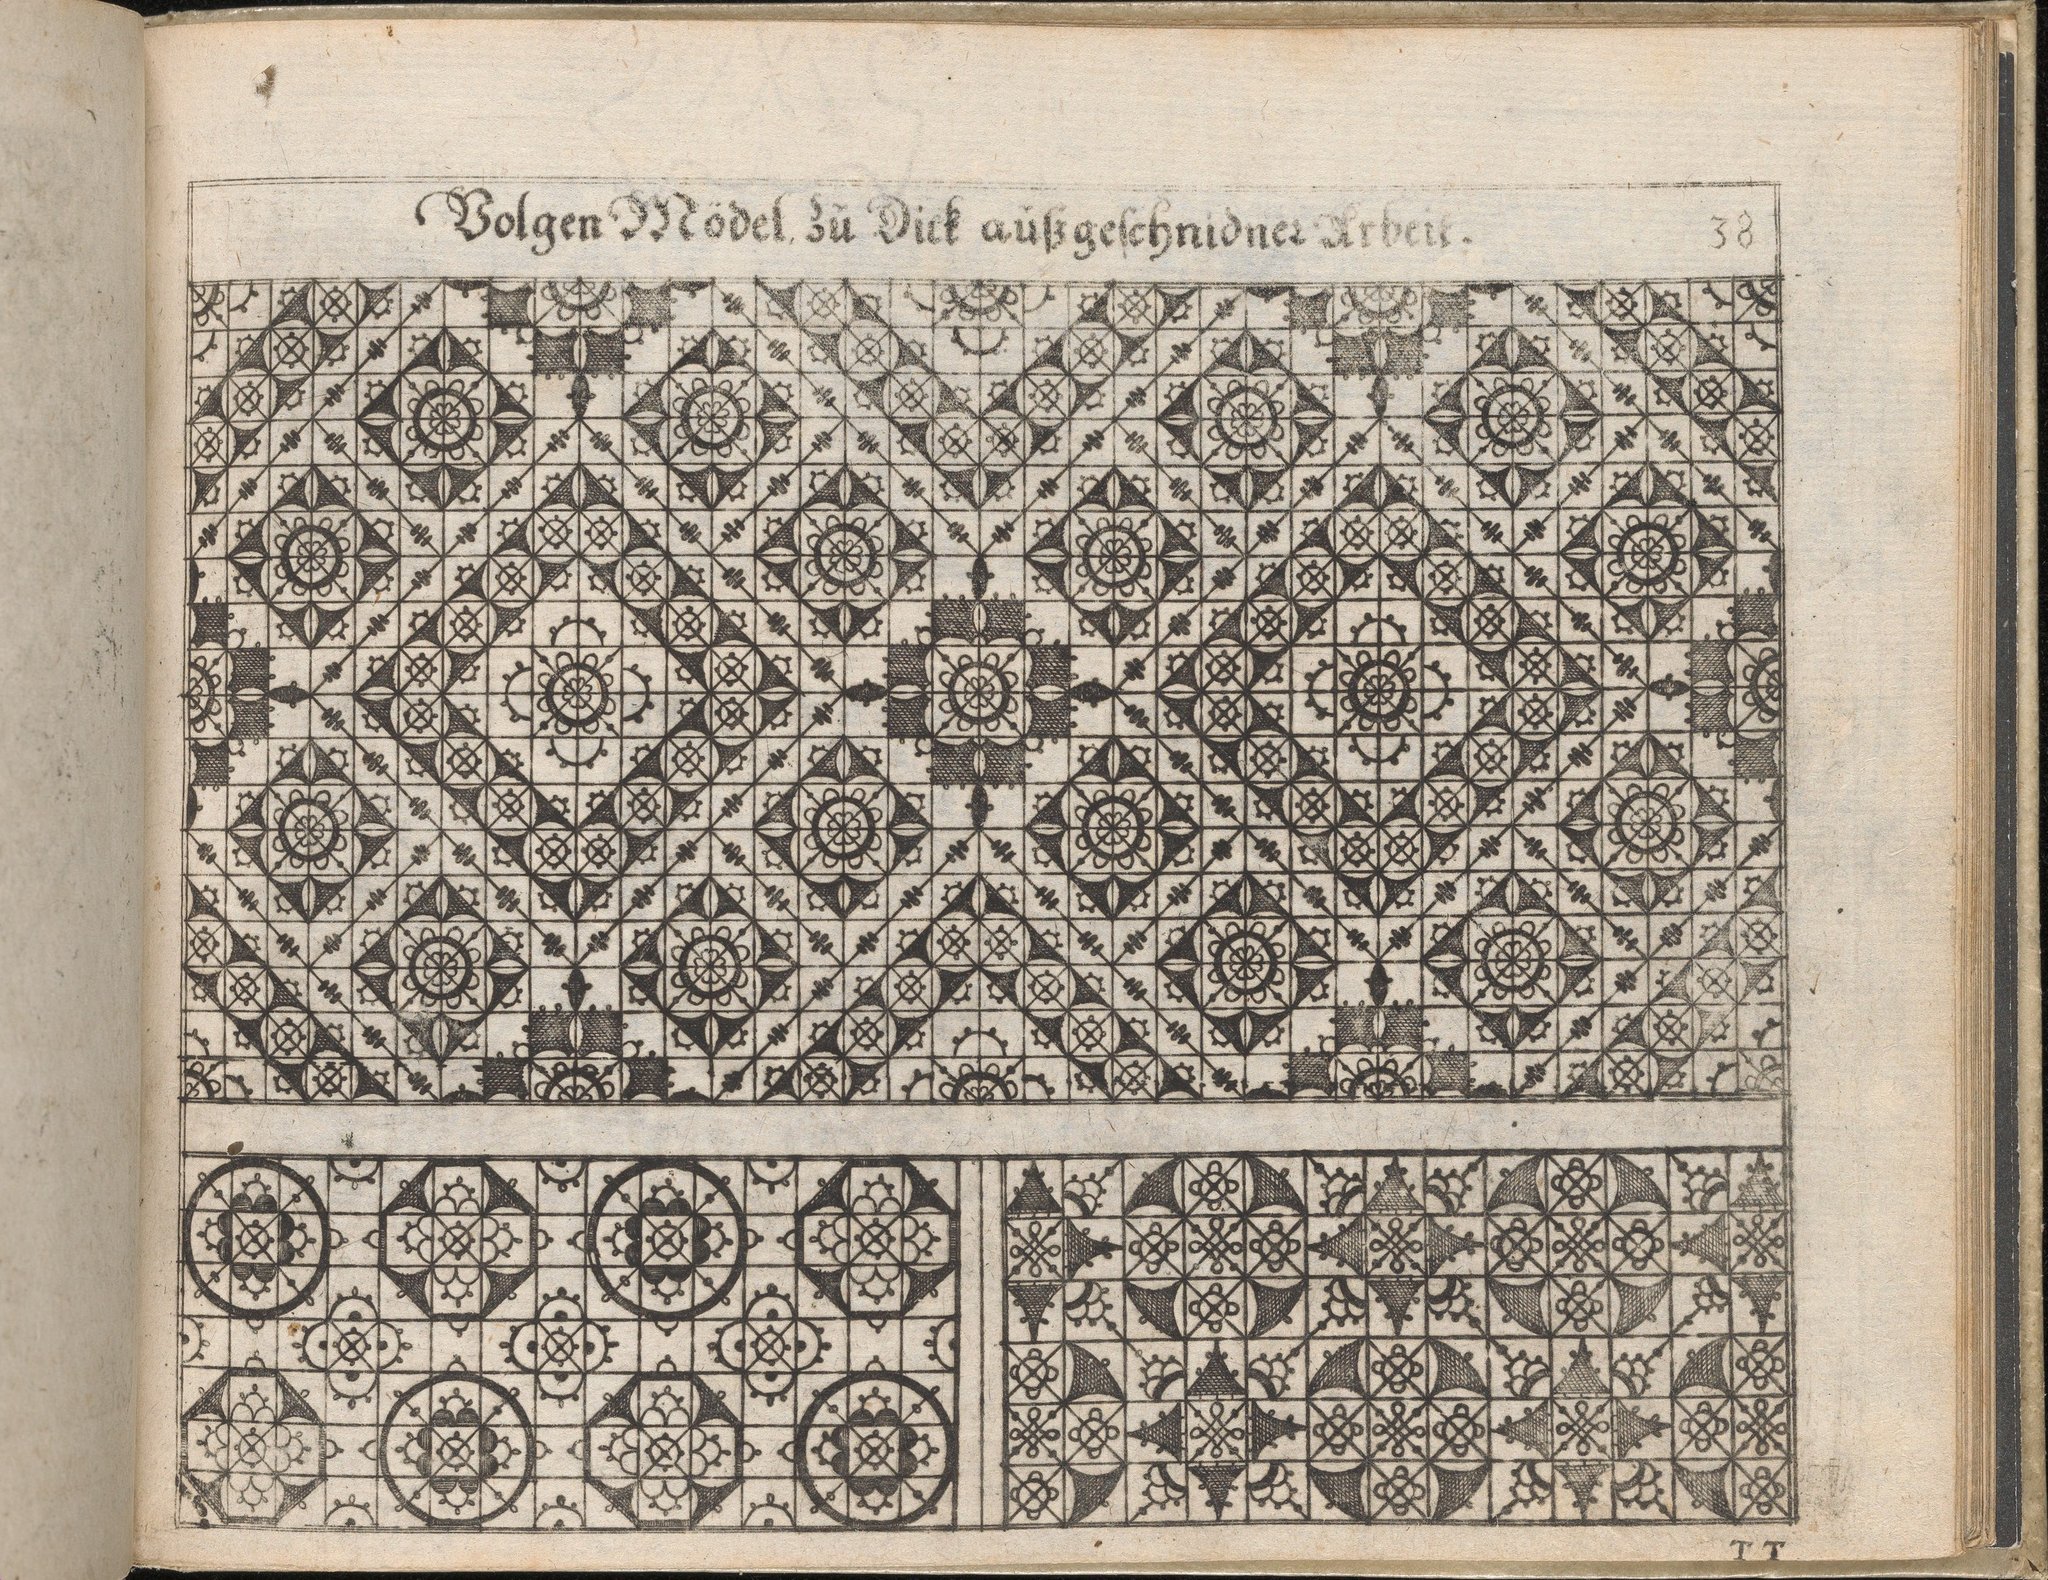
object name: book print ornament architecture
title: Newes Modelbuch in Kupffer (Page 46r)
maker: johann sibmacher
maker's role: artist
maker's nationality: german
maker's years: 1590-1611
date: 1604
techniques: etching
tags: ornament